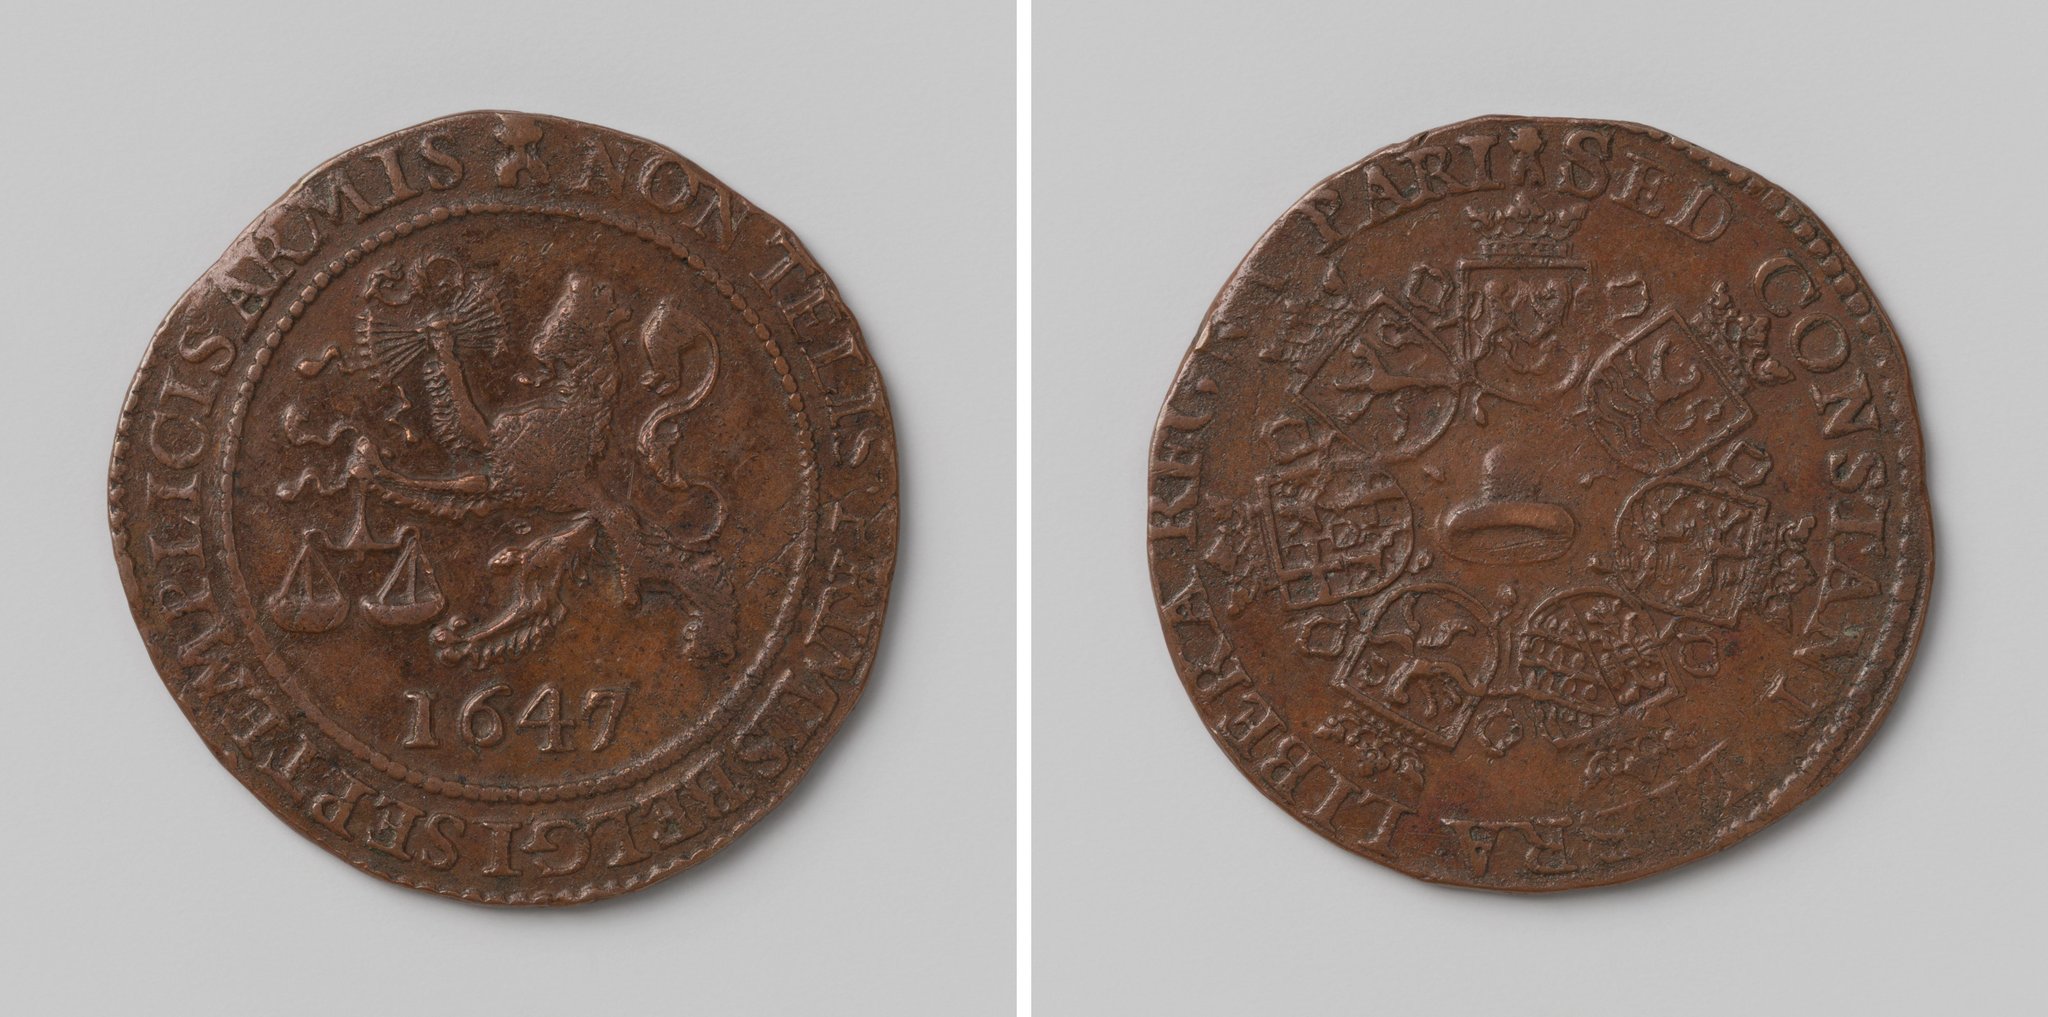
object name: jeton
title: Vredesonderhandelingen te Munster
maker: johannes looff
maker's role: die cutter, draughtsman, print maker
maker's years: -1651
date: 1647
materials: copper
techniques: striking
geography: middelburg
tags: münster, tachtigjarige oorlog, vrede van münster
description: Koperen penning. Voorzijde: gekroonde leeuw met bundel van zeven pijlen in rechter- en weegschaal in linkerklauw boven jaartal binnen omschrift. Keerzijde: vrijheidshoed, omgeven door rand van zeven met lint samengebonden gekroonde wapenschilden binnen omschrift